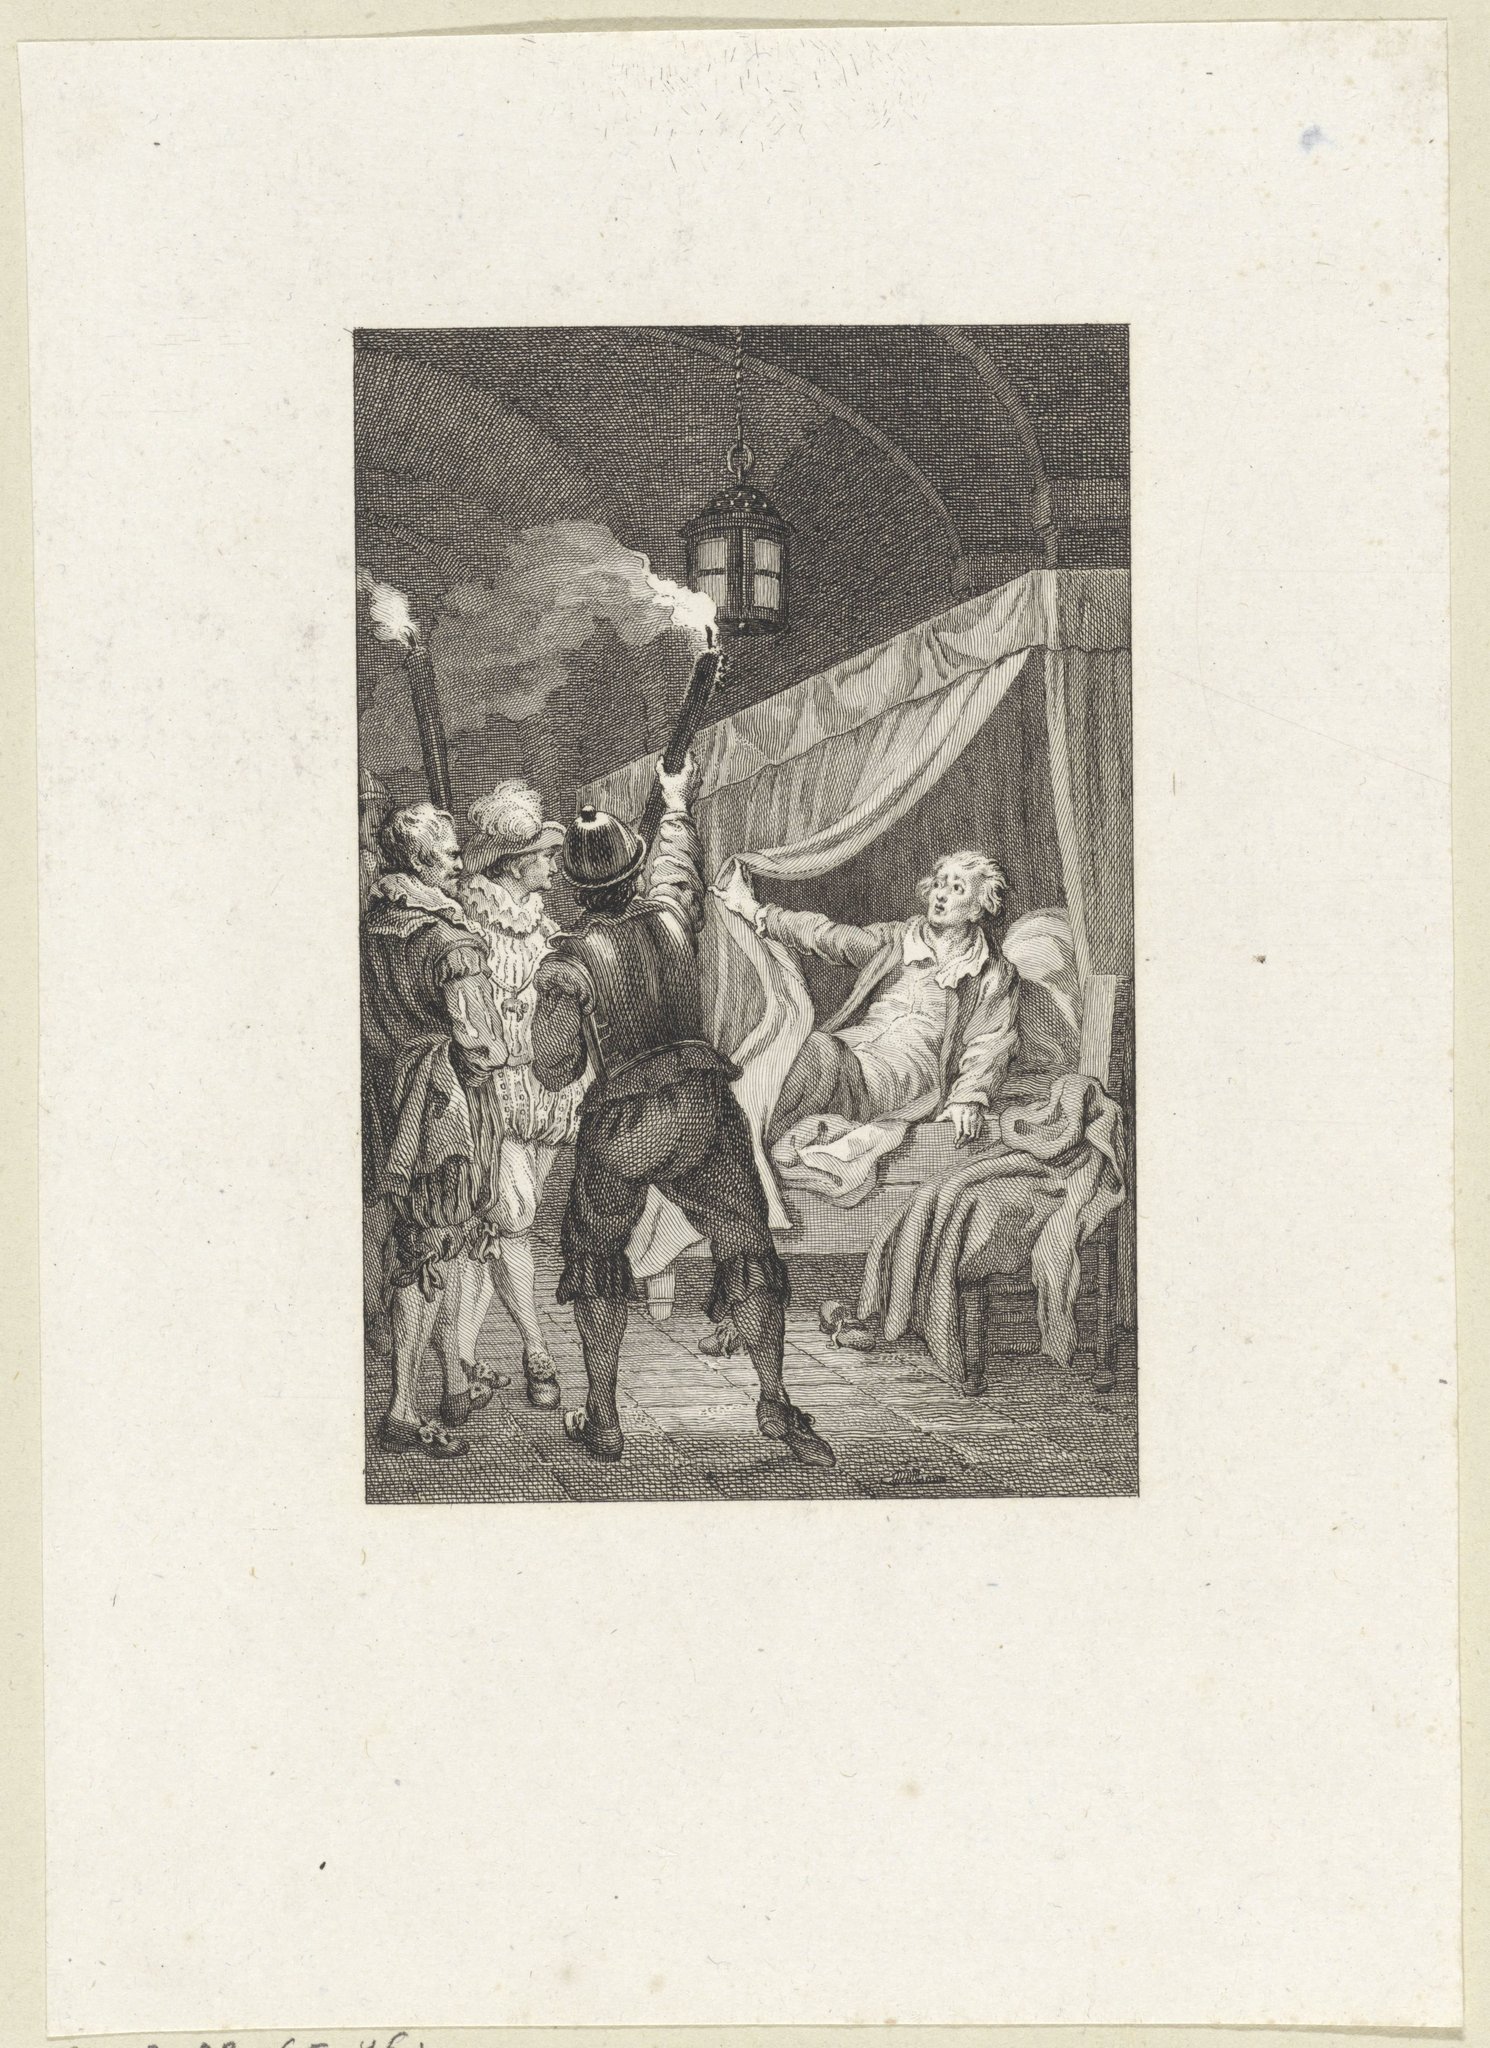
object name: print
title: Man wordt door soldaten van zijn bed gelicht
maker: reinier vinkeles (i)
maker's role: draughtsman, print maker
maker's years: 1741-1816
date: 1790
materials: paper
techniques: engraving, etching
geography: amsterdam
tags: torch, waking up, the soldier; the soldier's life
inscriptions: collector's mark: Lugt 240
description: Proefdruk van een prent die mogelijk ook gebruikt is als illustratie in: Goethe, Johann Wolfgang von. Egmont. Treurspel. In 5 bedryven. Amsterdam: erven van Pieter Meĳer en Gerrit Warnars, 1790.